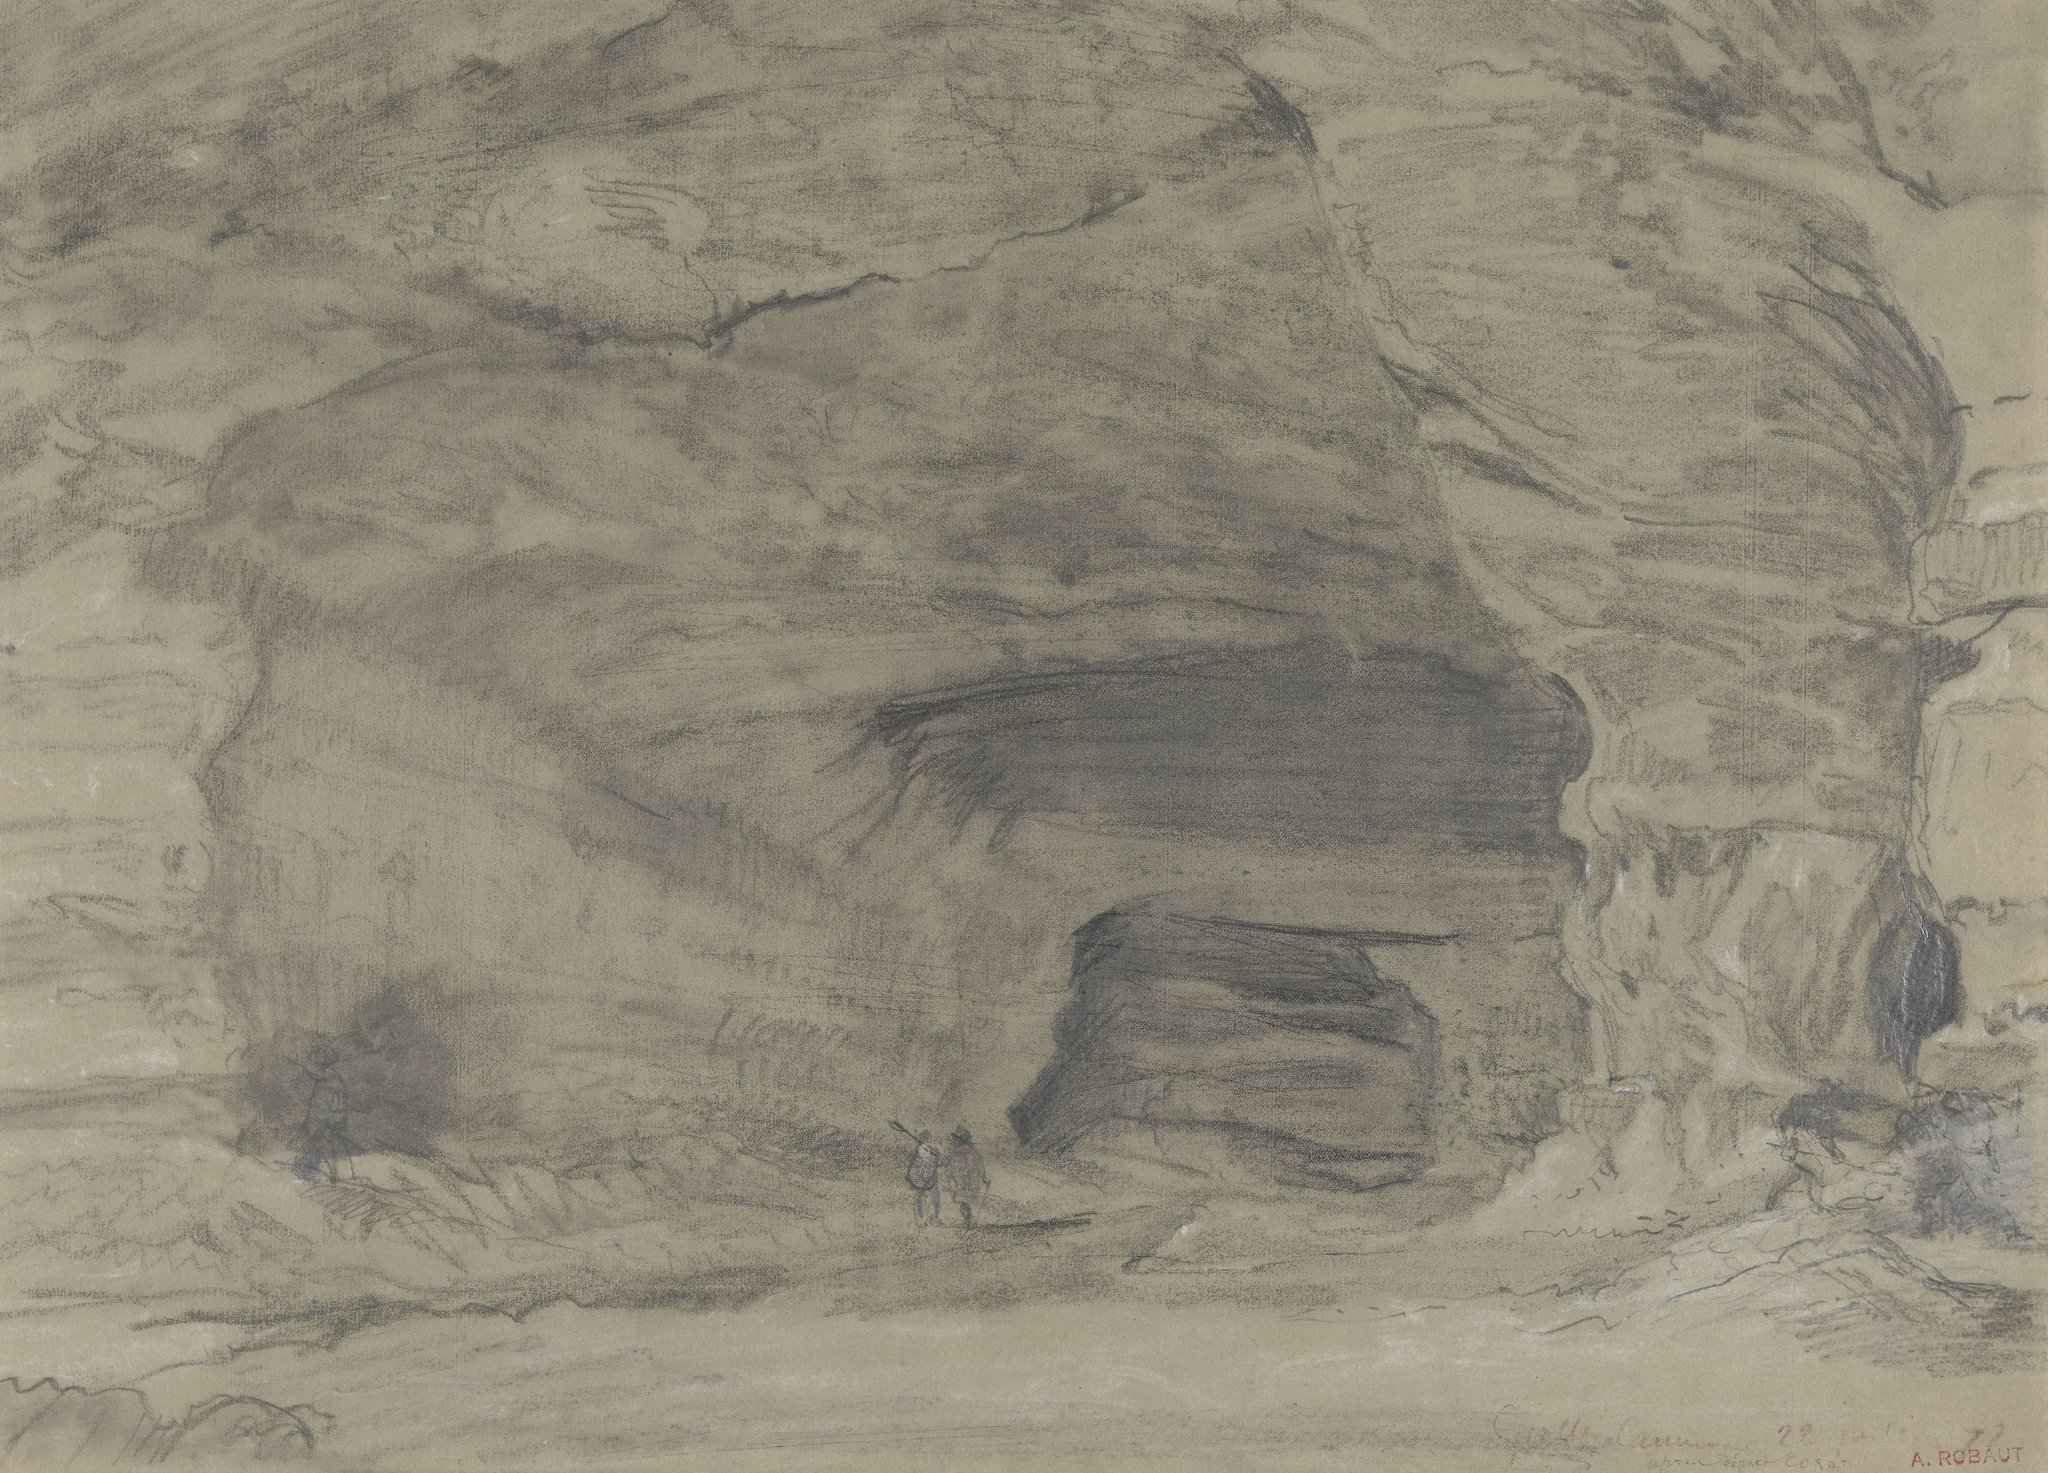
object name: drawing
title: Boerderij tussen bomen aan de Sloterweg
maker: jacob ernst marcus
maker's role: draughtsman, print maker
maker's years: 1774-1826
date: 1807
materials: chalk, paper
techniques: brush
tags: farm (building)